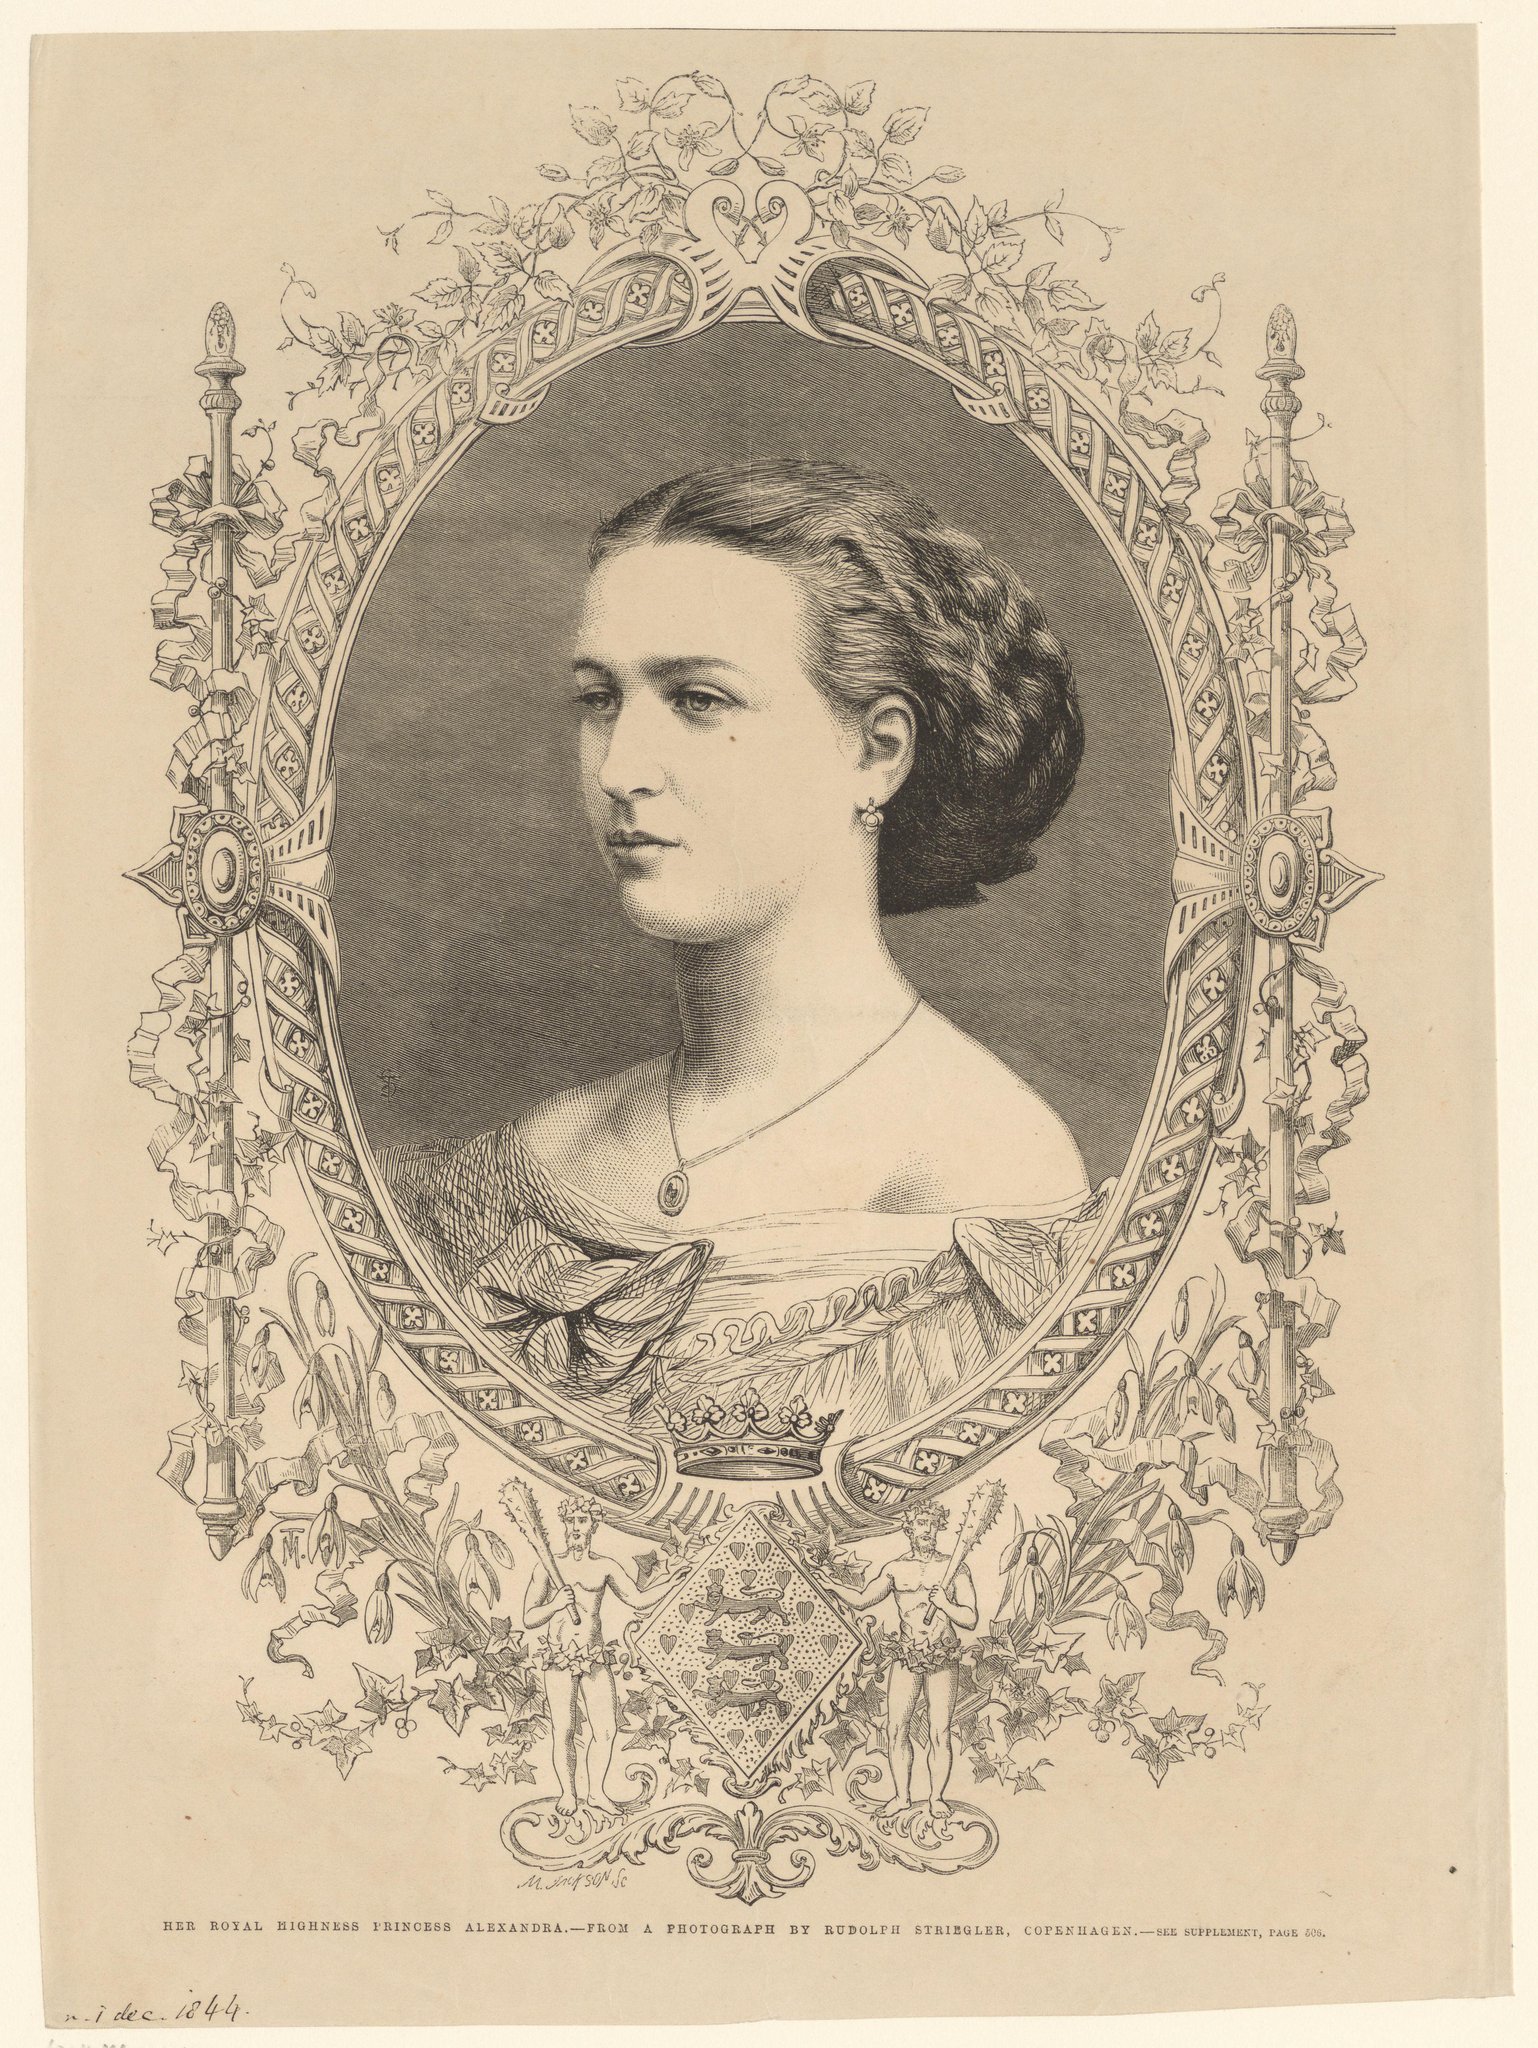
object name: print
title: Portret van Alexandra van Denemarken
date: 1862-1903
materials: paper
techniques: engraving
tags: copenhagen (city), adult woman, historical persons, ornament ~ cartouche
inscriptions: collector's mark: Lugt 2228